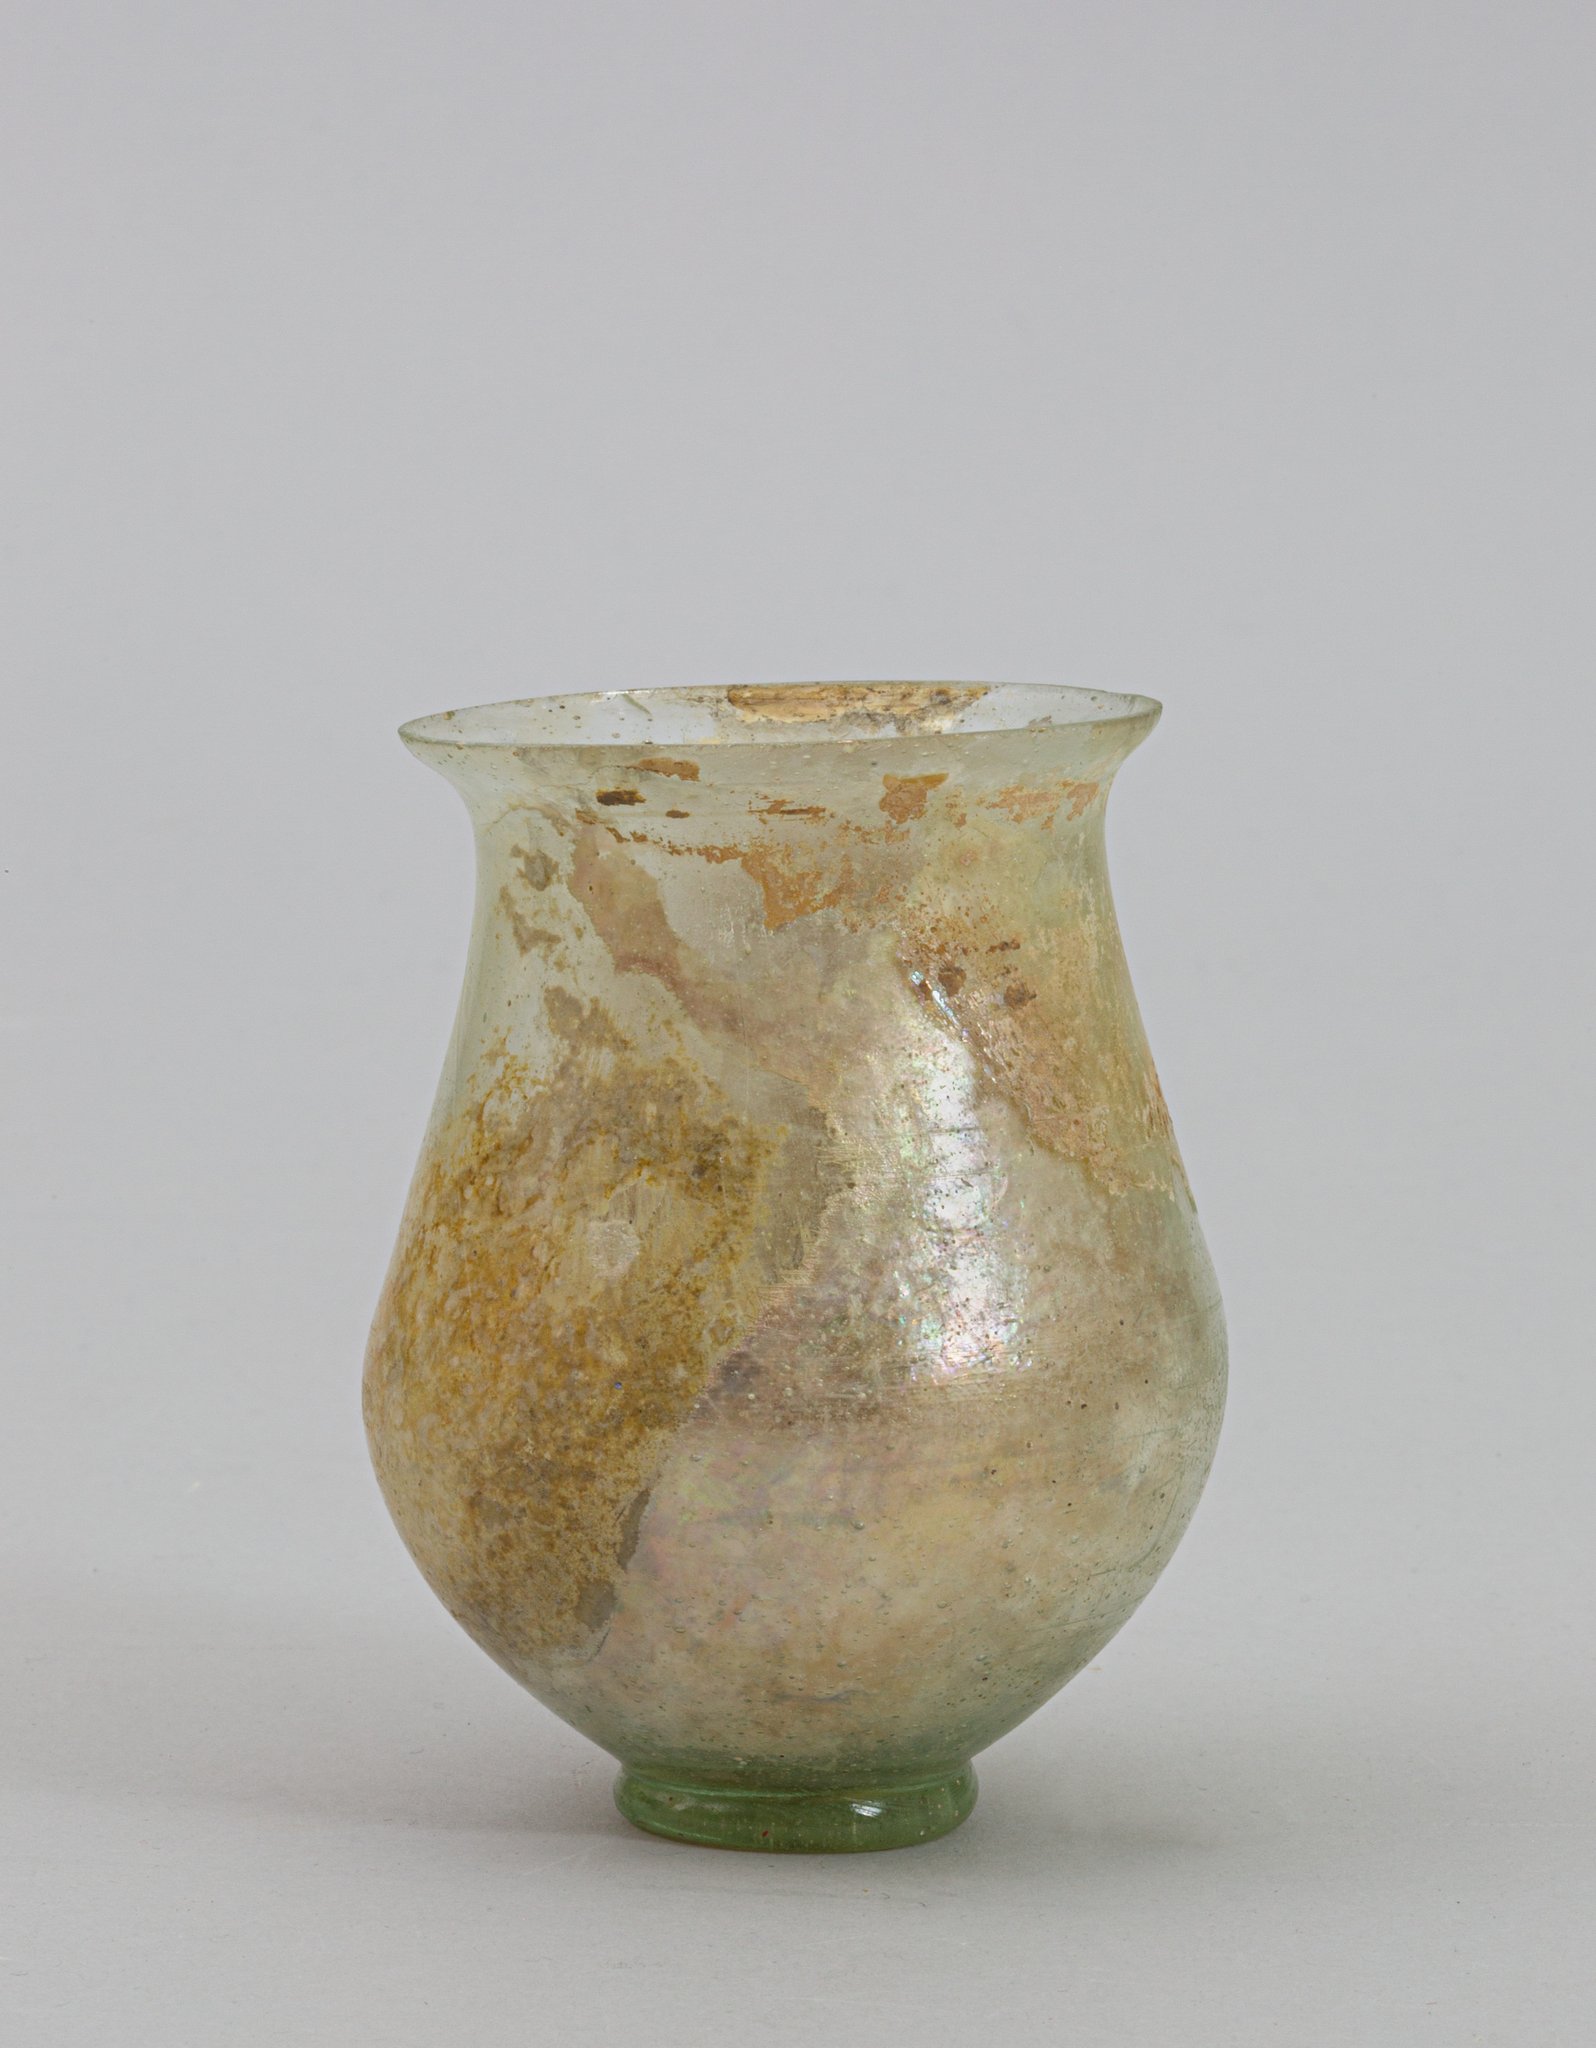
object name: beaker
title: Glass beaker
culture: roman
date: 201-400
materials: glass